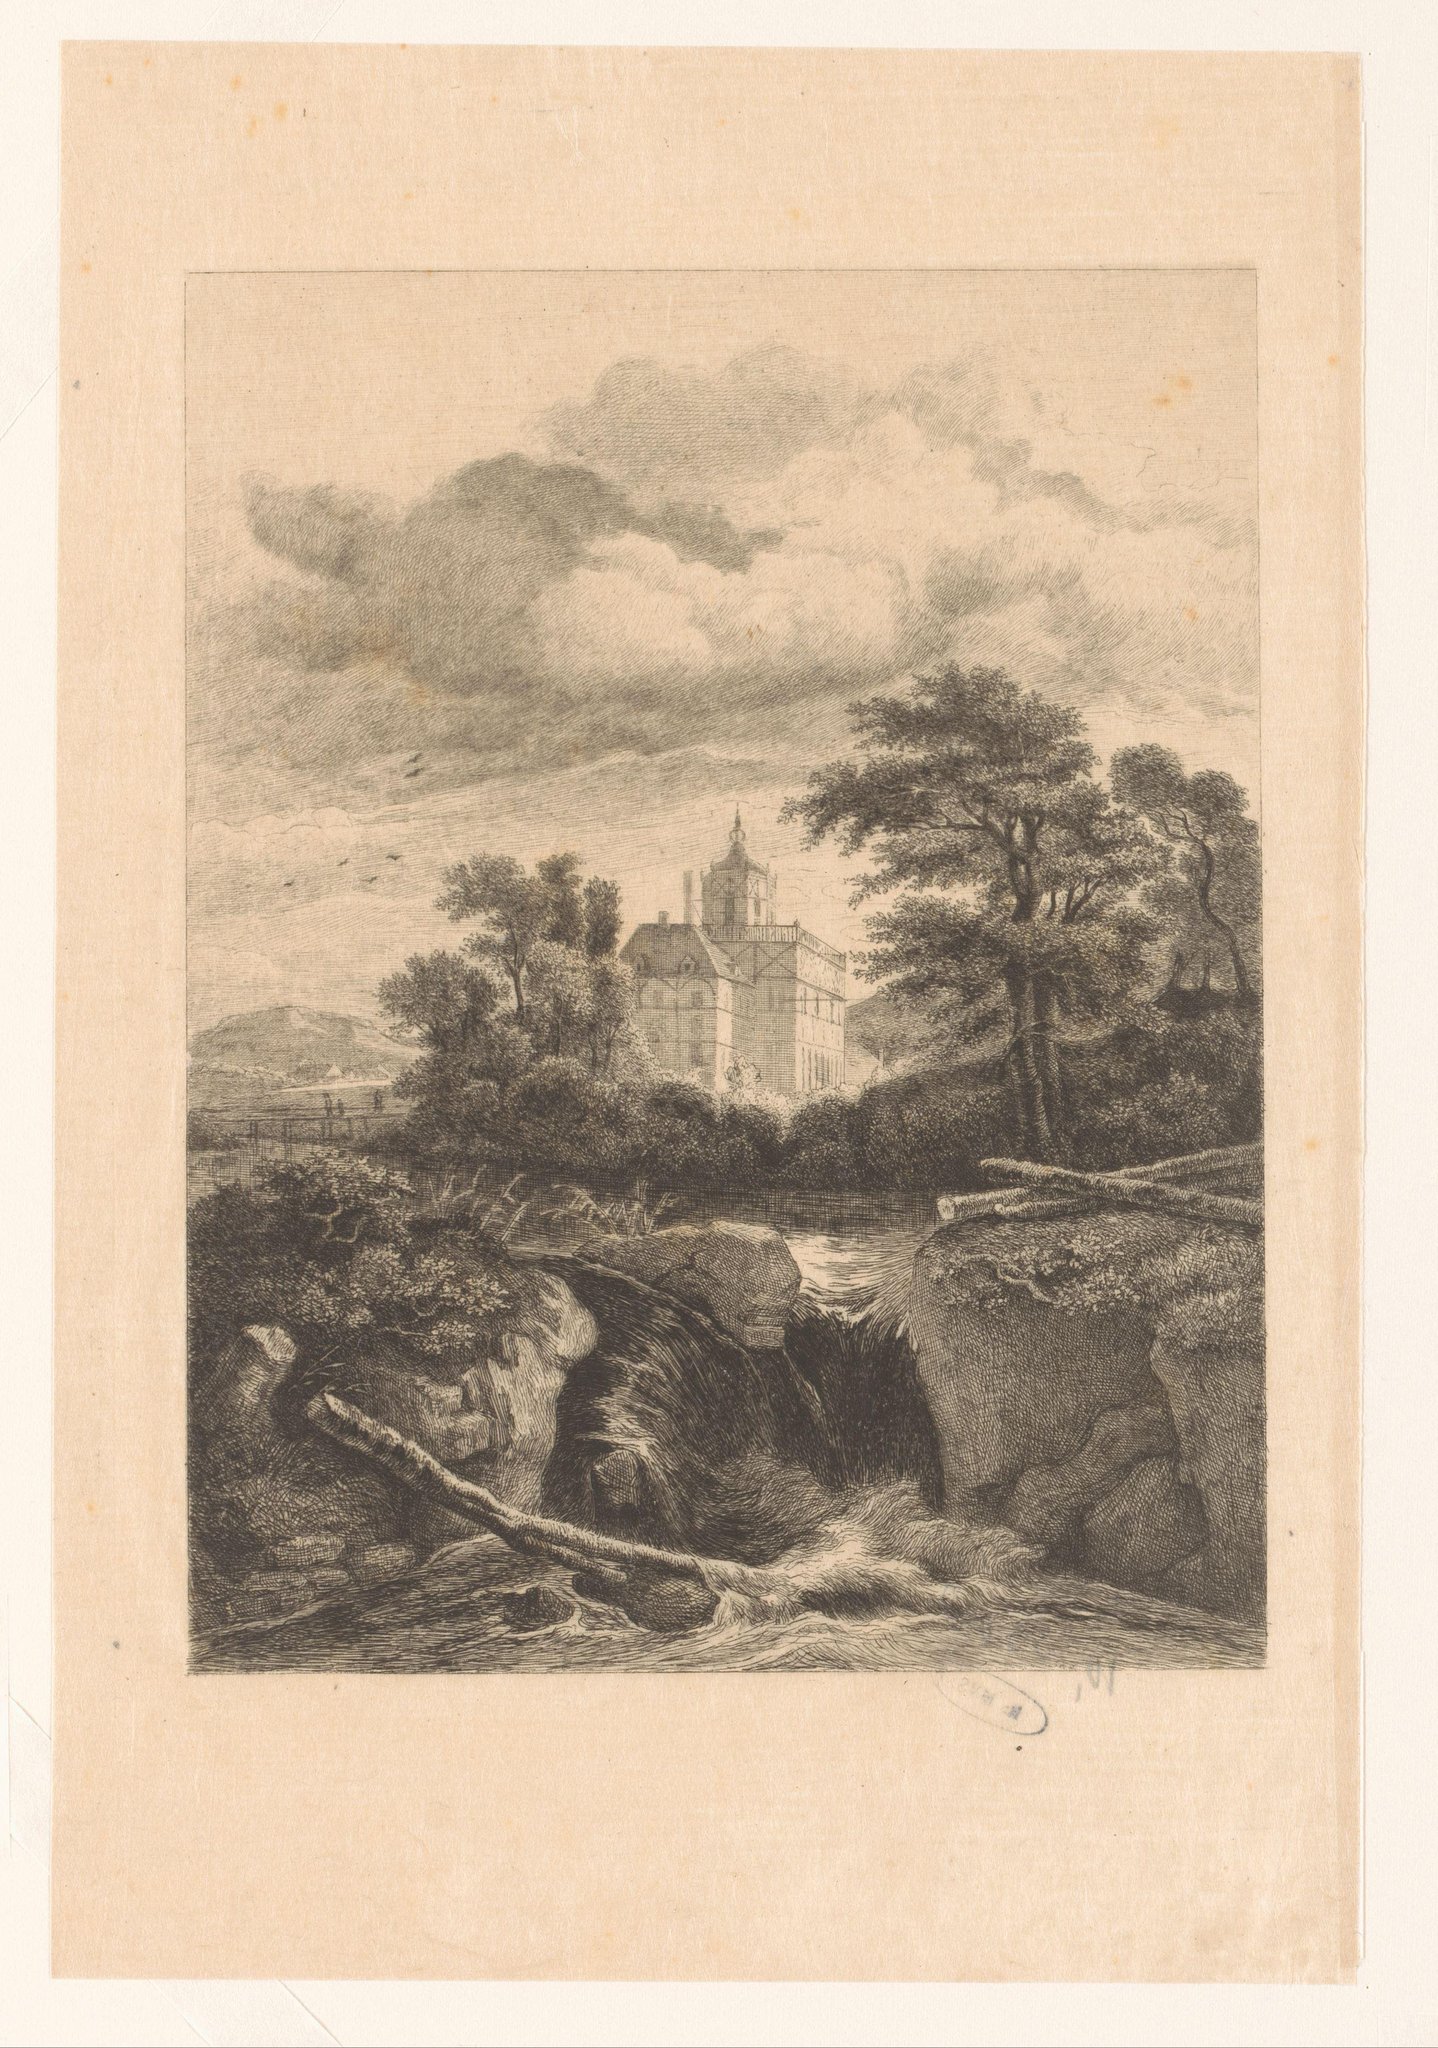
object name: print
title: Landschap met een waterval en op de achtergrond een kasteel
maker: léopold flameng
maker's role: print maker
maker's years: 1831-1911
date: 1841-1910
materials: paper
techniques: etching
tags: waterfall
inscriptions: collector's mark: Lugt 2228